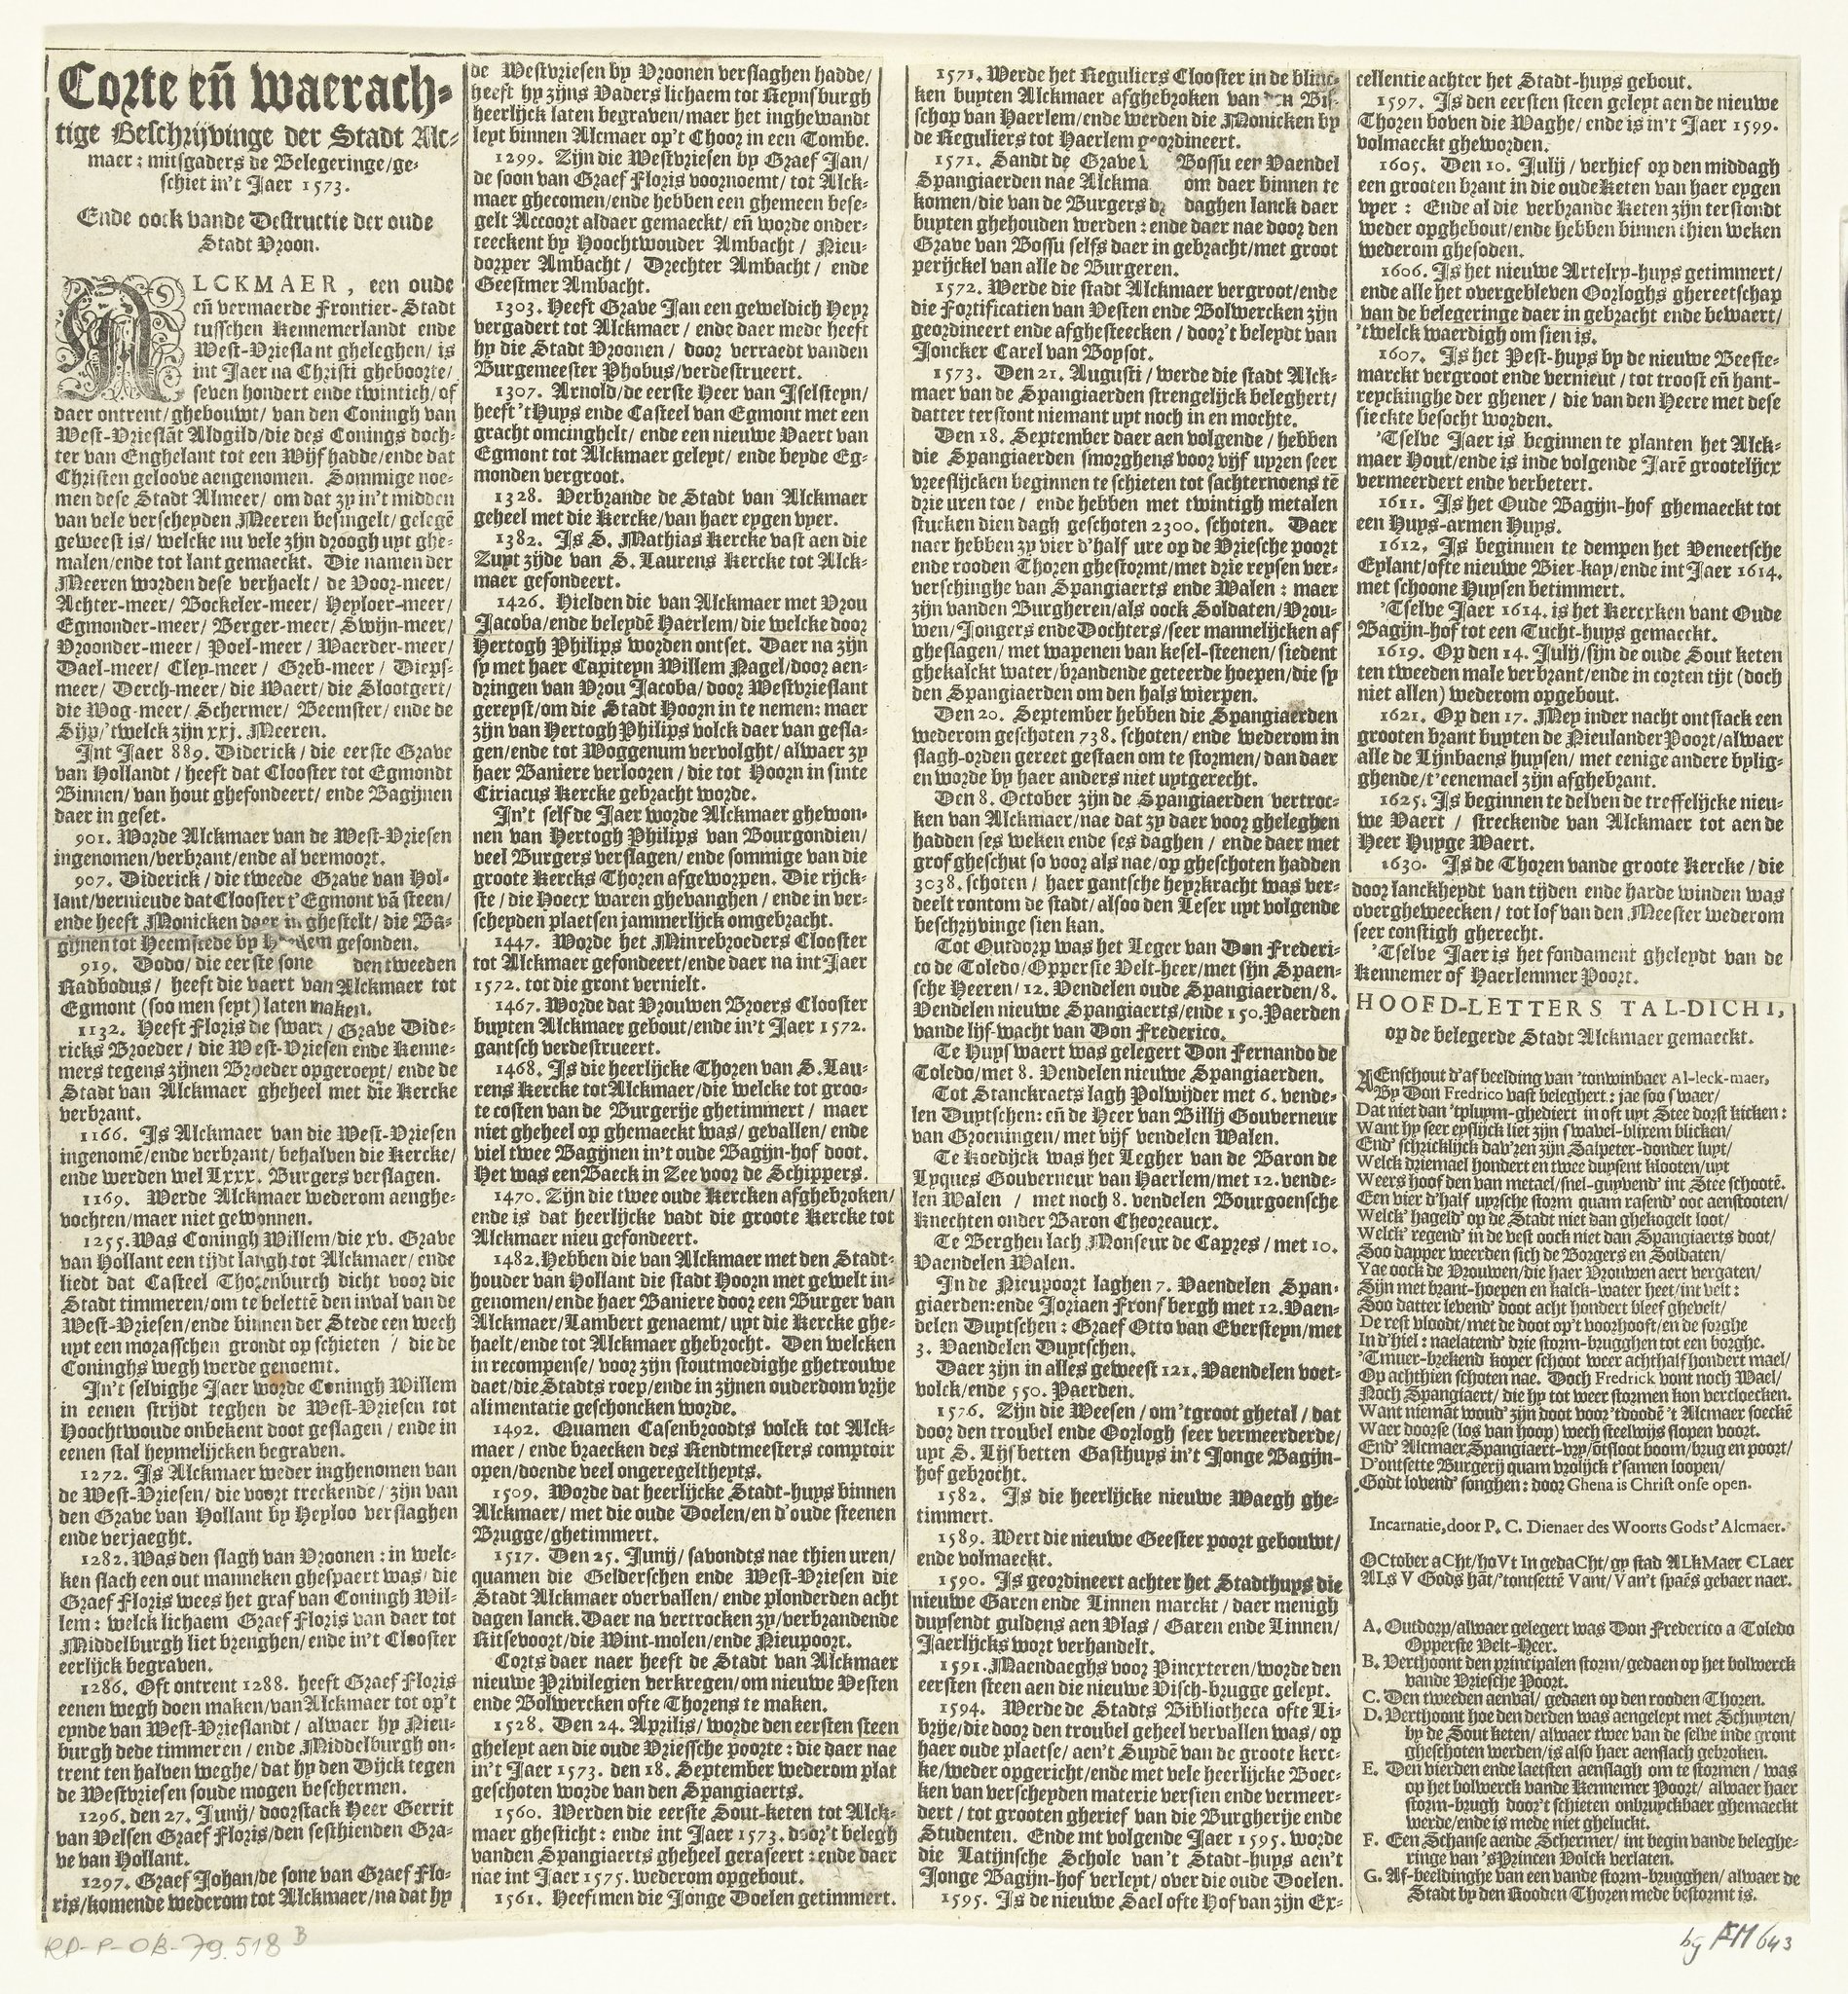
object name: text sheet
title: Tekstblad behorende bij de kaart met het beleg van Alkmaar, 1573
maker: Anonymous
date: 1630-1632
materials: paper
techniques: letterpress printing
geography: northern netherlands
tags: alkmaar, beleg van alkmaar (1573)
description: Door Muller gevoegd bij de kaart beschrijven onder hetzelfde nummer. Tekst is echter van na 1630, de kaart lijkt eigentijds met het beleg. In de collectie van de Atlas Van Stolk (nr. 508) bevindt zich een groot blad samengesteld uit de prent van het beleg RP-P-OB-79.518A gecombineerd met deze kolommen tekst waarin gebeurtenissen tot in het jaar 1630 worden beschreven plus meer teksten, met het adres van de uitgever Jan Volckersz te Alkmaar. Ook de prent van Rienier van Persijn (RP-P-OB-78.150) over de verwoesting van Vronen in 1297 maakt onderdeel uit van dit samengesteld geheel dat dus dateert van na 1630.